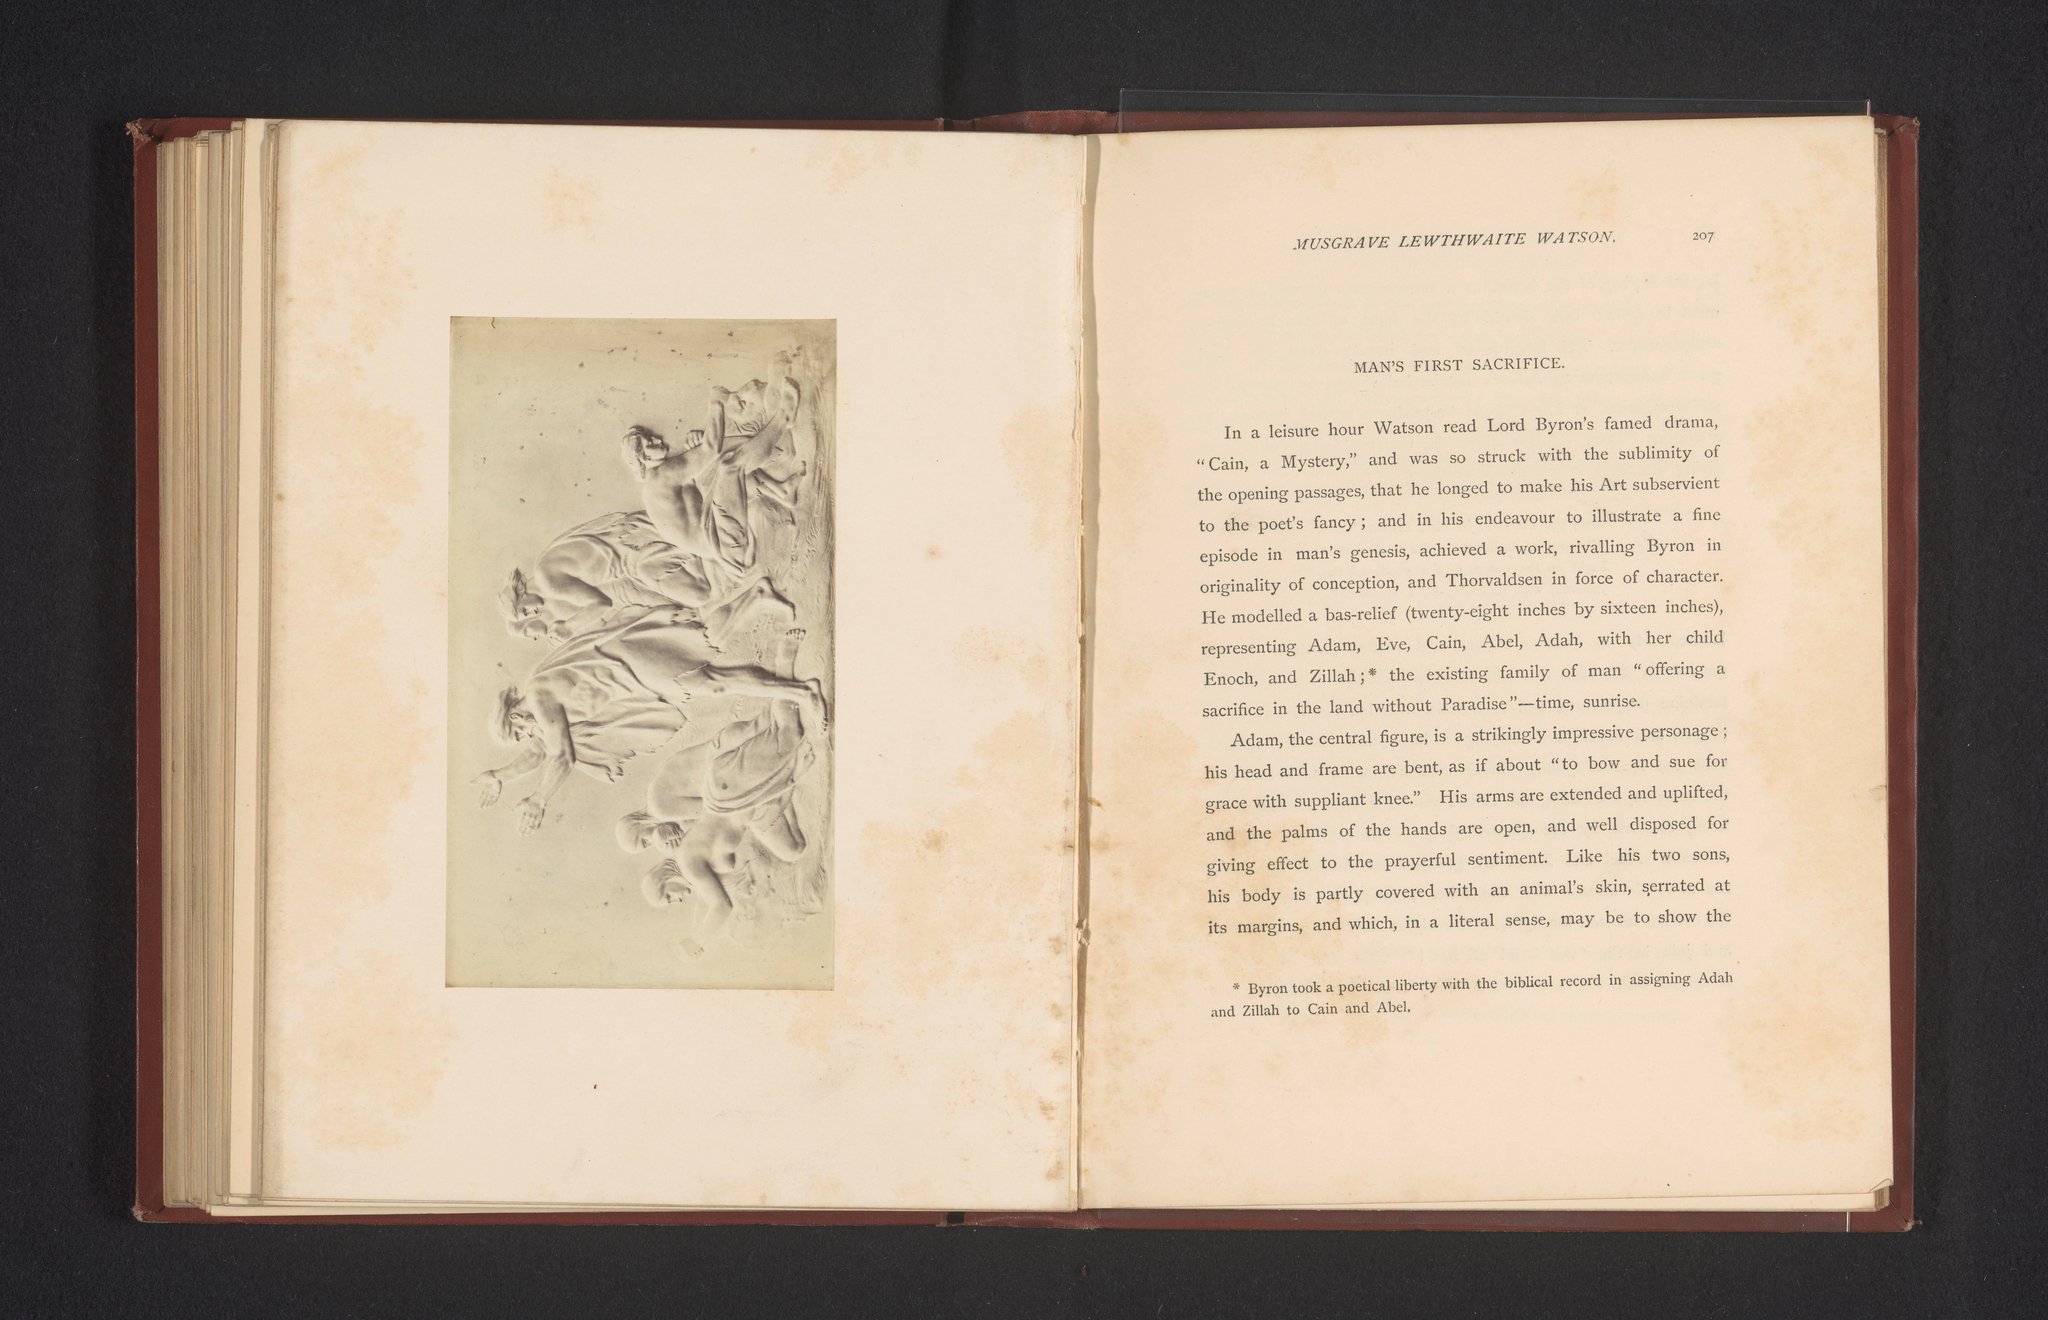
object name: page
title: Reliëf, voorstellende het offer van Adam en Eva en hun kinderen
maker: Anonymous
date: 1861-1866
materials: photographic support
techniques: albumen print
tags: the labours of adam and eve; infancy of cain and abel (genesis 4:1-2), sculpture (+ relief ~ sculpture)